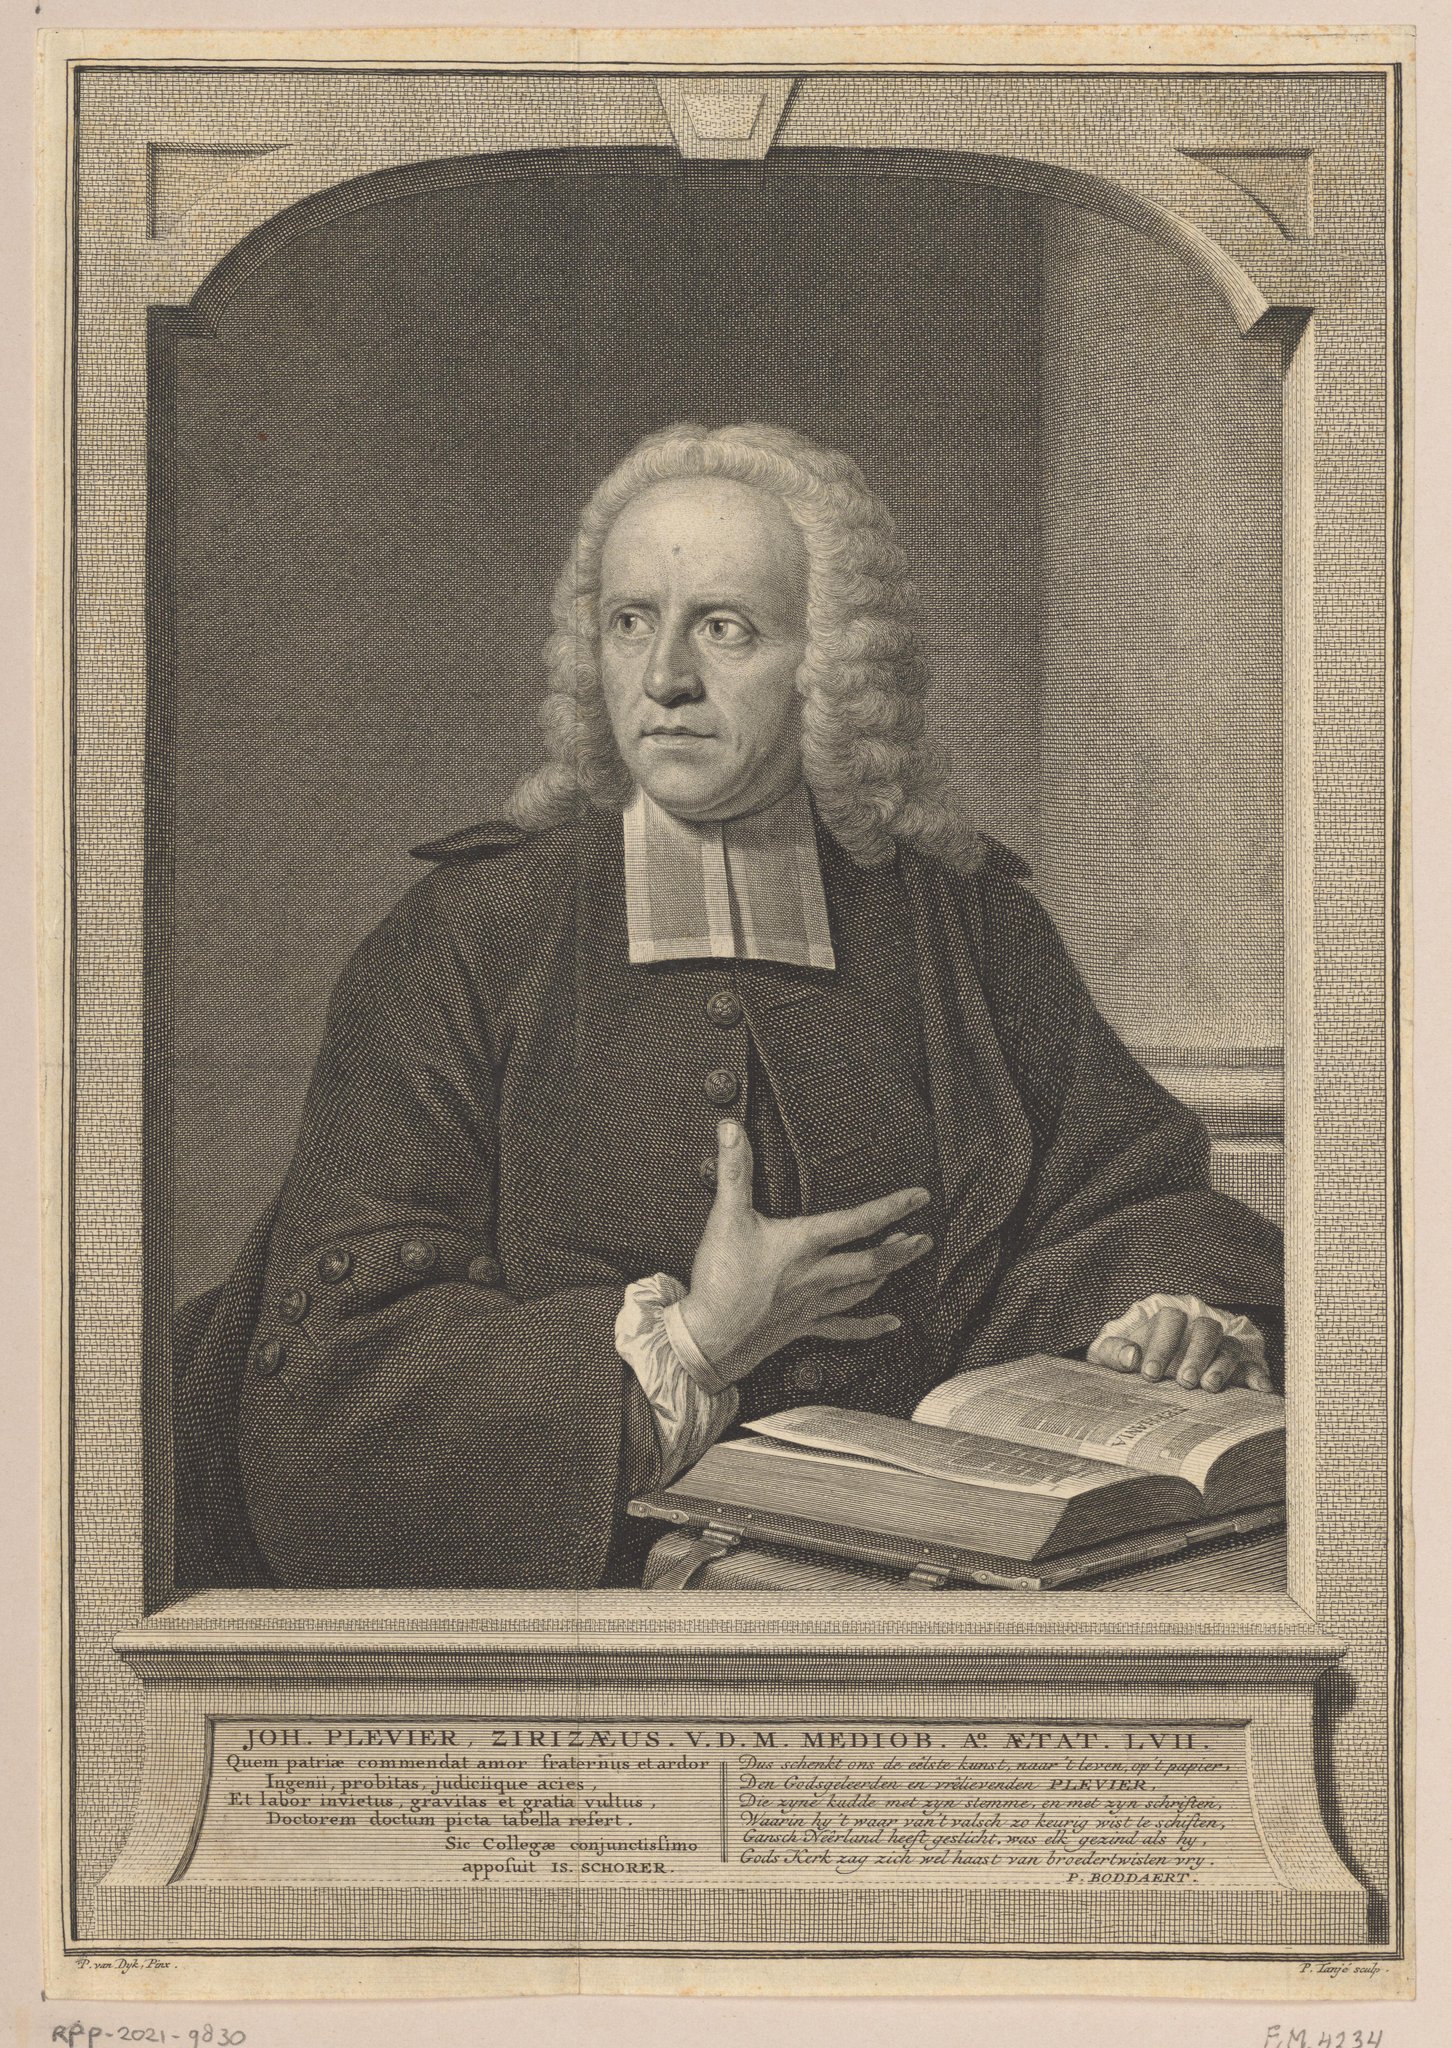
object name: print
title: Portret van Johannes Plevier op 57-jarige leeftijd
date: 1742-1761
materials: paper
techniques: engraving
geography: amsterdam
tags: middelburg, adult man, historical persons